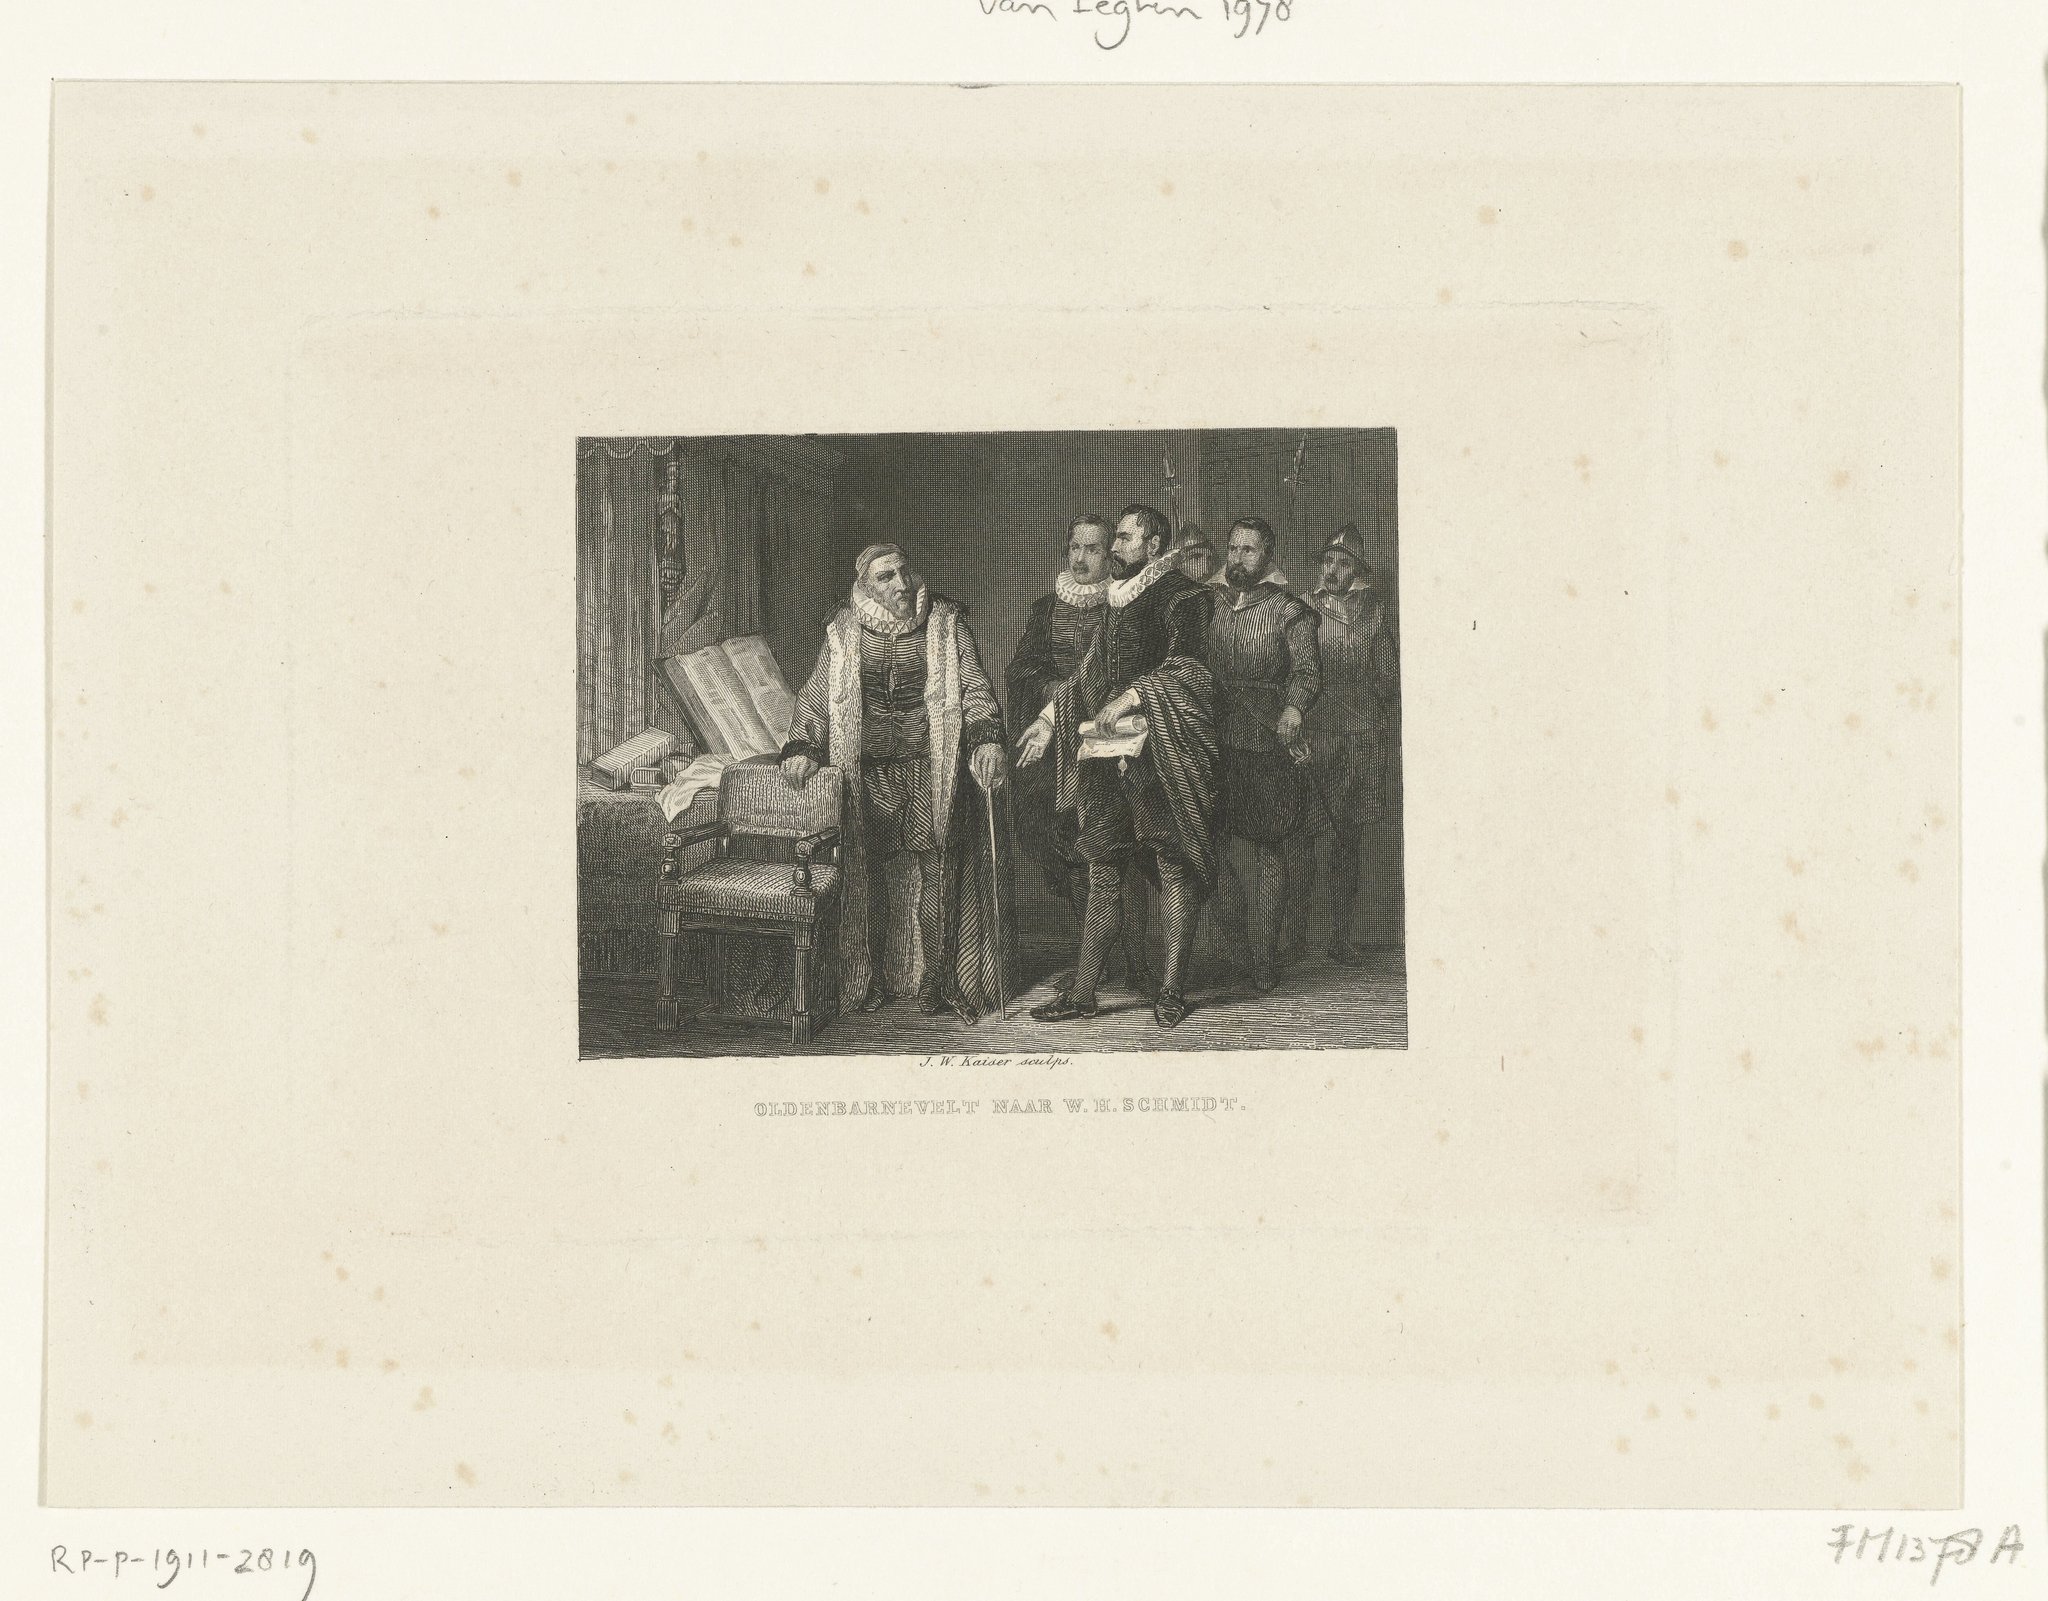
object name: history print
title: Oldenbarnevelt ontvangt aanzegging van zijn doodsvonnis, 1619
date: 1844-1899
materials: paper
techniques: engraving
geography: netherlands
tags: the hague, johan van oldenbarnevelt, person under sentence of death hears that he is to be executed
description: Johan van Oldenbarnevelt verneemt van de gerechtsambtenaren Van Leeuwen en Sylla dat zijn doodvonnis de volgende dag voltrokken zal worden, 12 mei 1619. Staande bij een tafel met boeken, geleund op zijn stok en met zijn hand op de rug van zijn stoel.